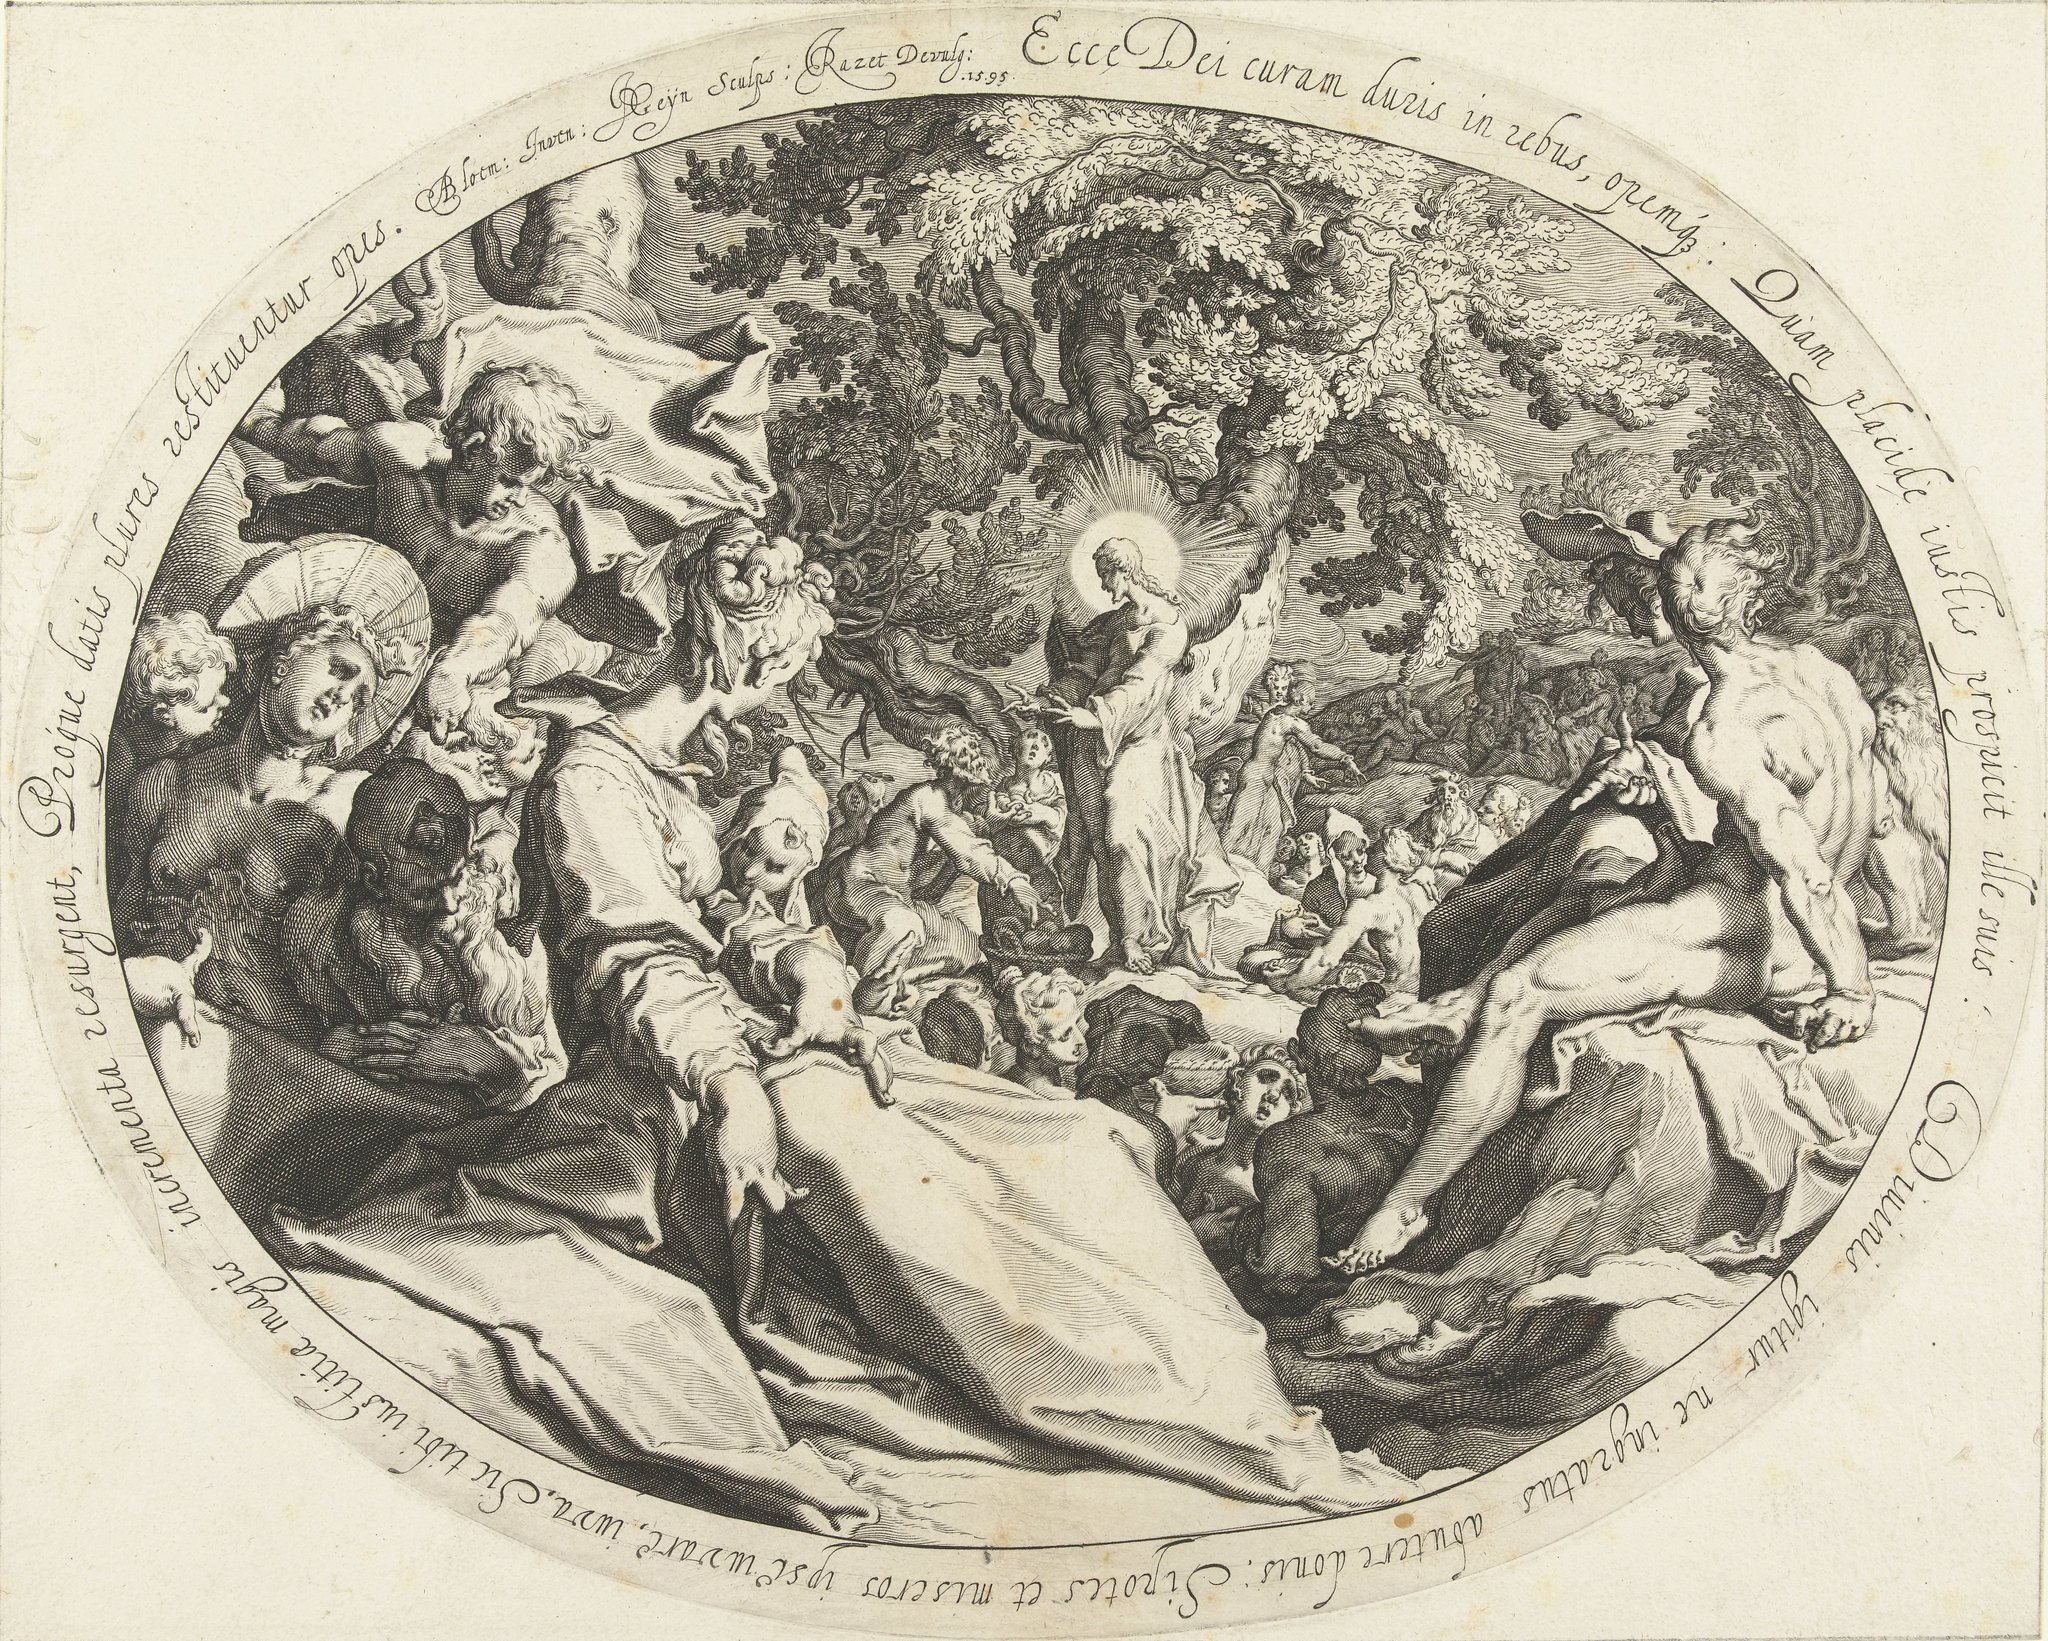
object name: print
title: Het wonder van de vijf broden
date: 1595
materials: paper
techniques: engraving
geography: netherlands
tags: multiplication of loaves and fishes for a multitude of four or five thousand people (matthew 14:13-21, 15:32-39; mark 6:32-44, 8:1-10; luke 9:10-17; john 6:1-14)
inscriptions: collector's mark: Lugt 240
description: Ovale voorstelling van Christus, staand in de buitenlucht bij een boom, temidden van een grote groep mensen. Aan zijn voeten een mand met broden. Links op de voorgrond twee vrouwen met opvallend kapsel en hoofddeksel. Om de voorstelling een Latijns randschrift.